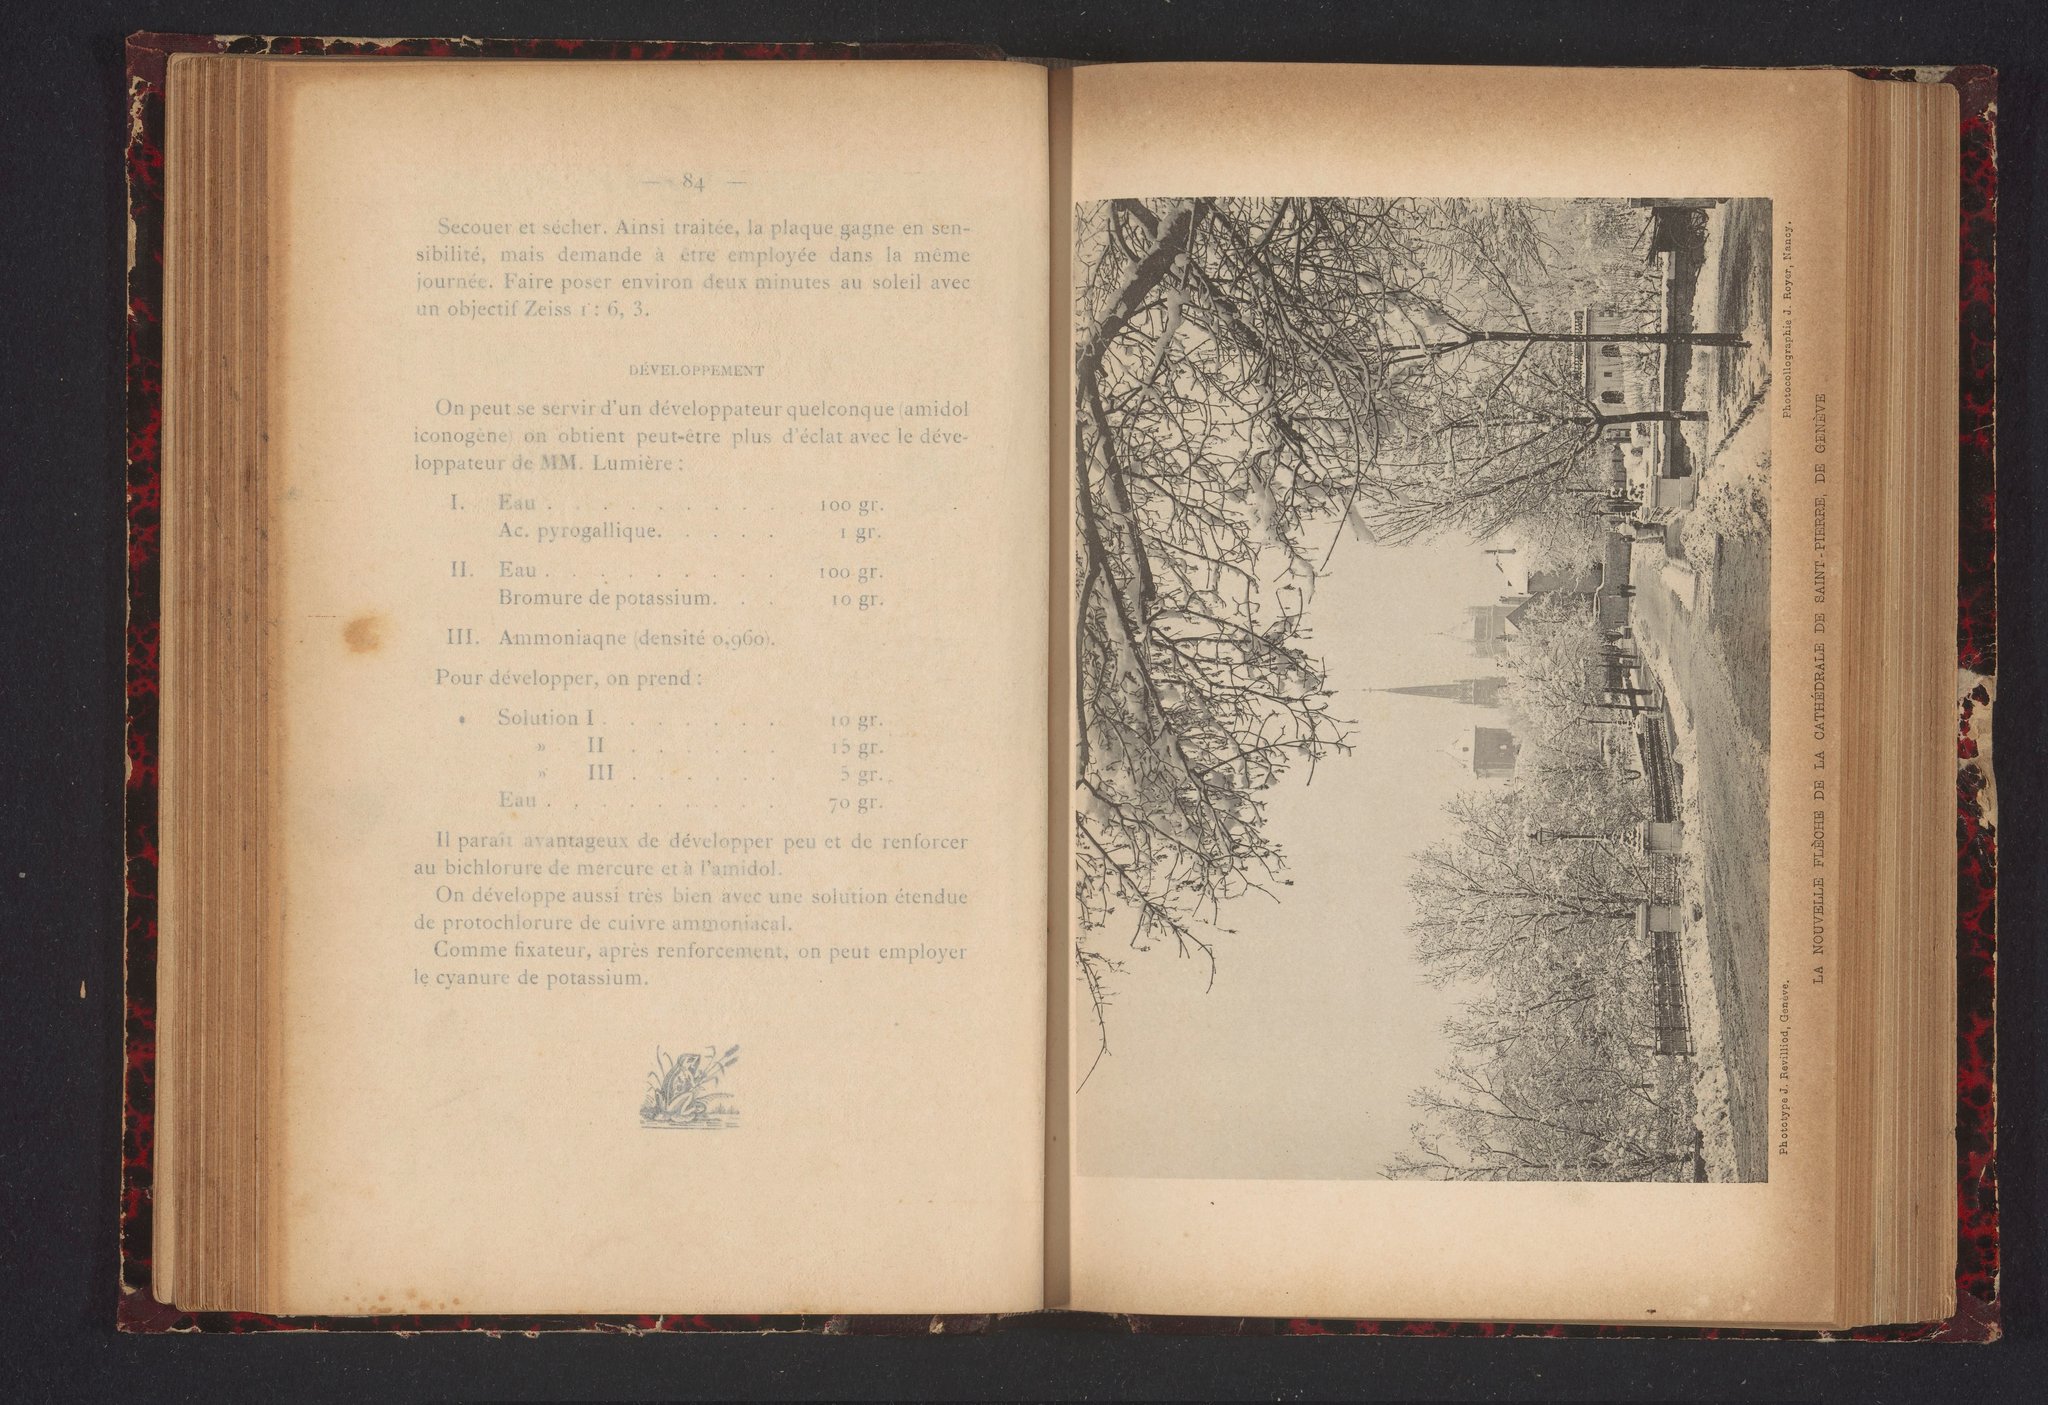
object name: photomechanical print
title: La Nouvelle Flèche de la Cathédrale de Saint-Pierre, de Genève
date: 1894-1899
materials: paper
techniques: photograph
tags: snow, prospect of city, town panorama, silhouette of city, parts of church exterior and annexes: tower